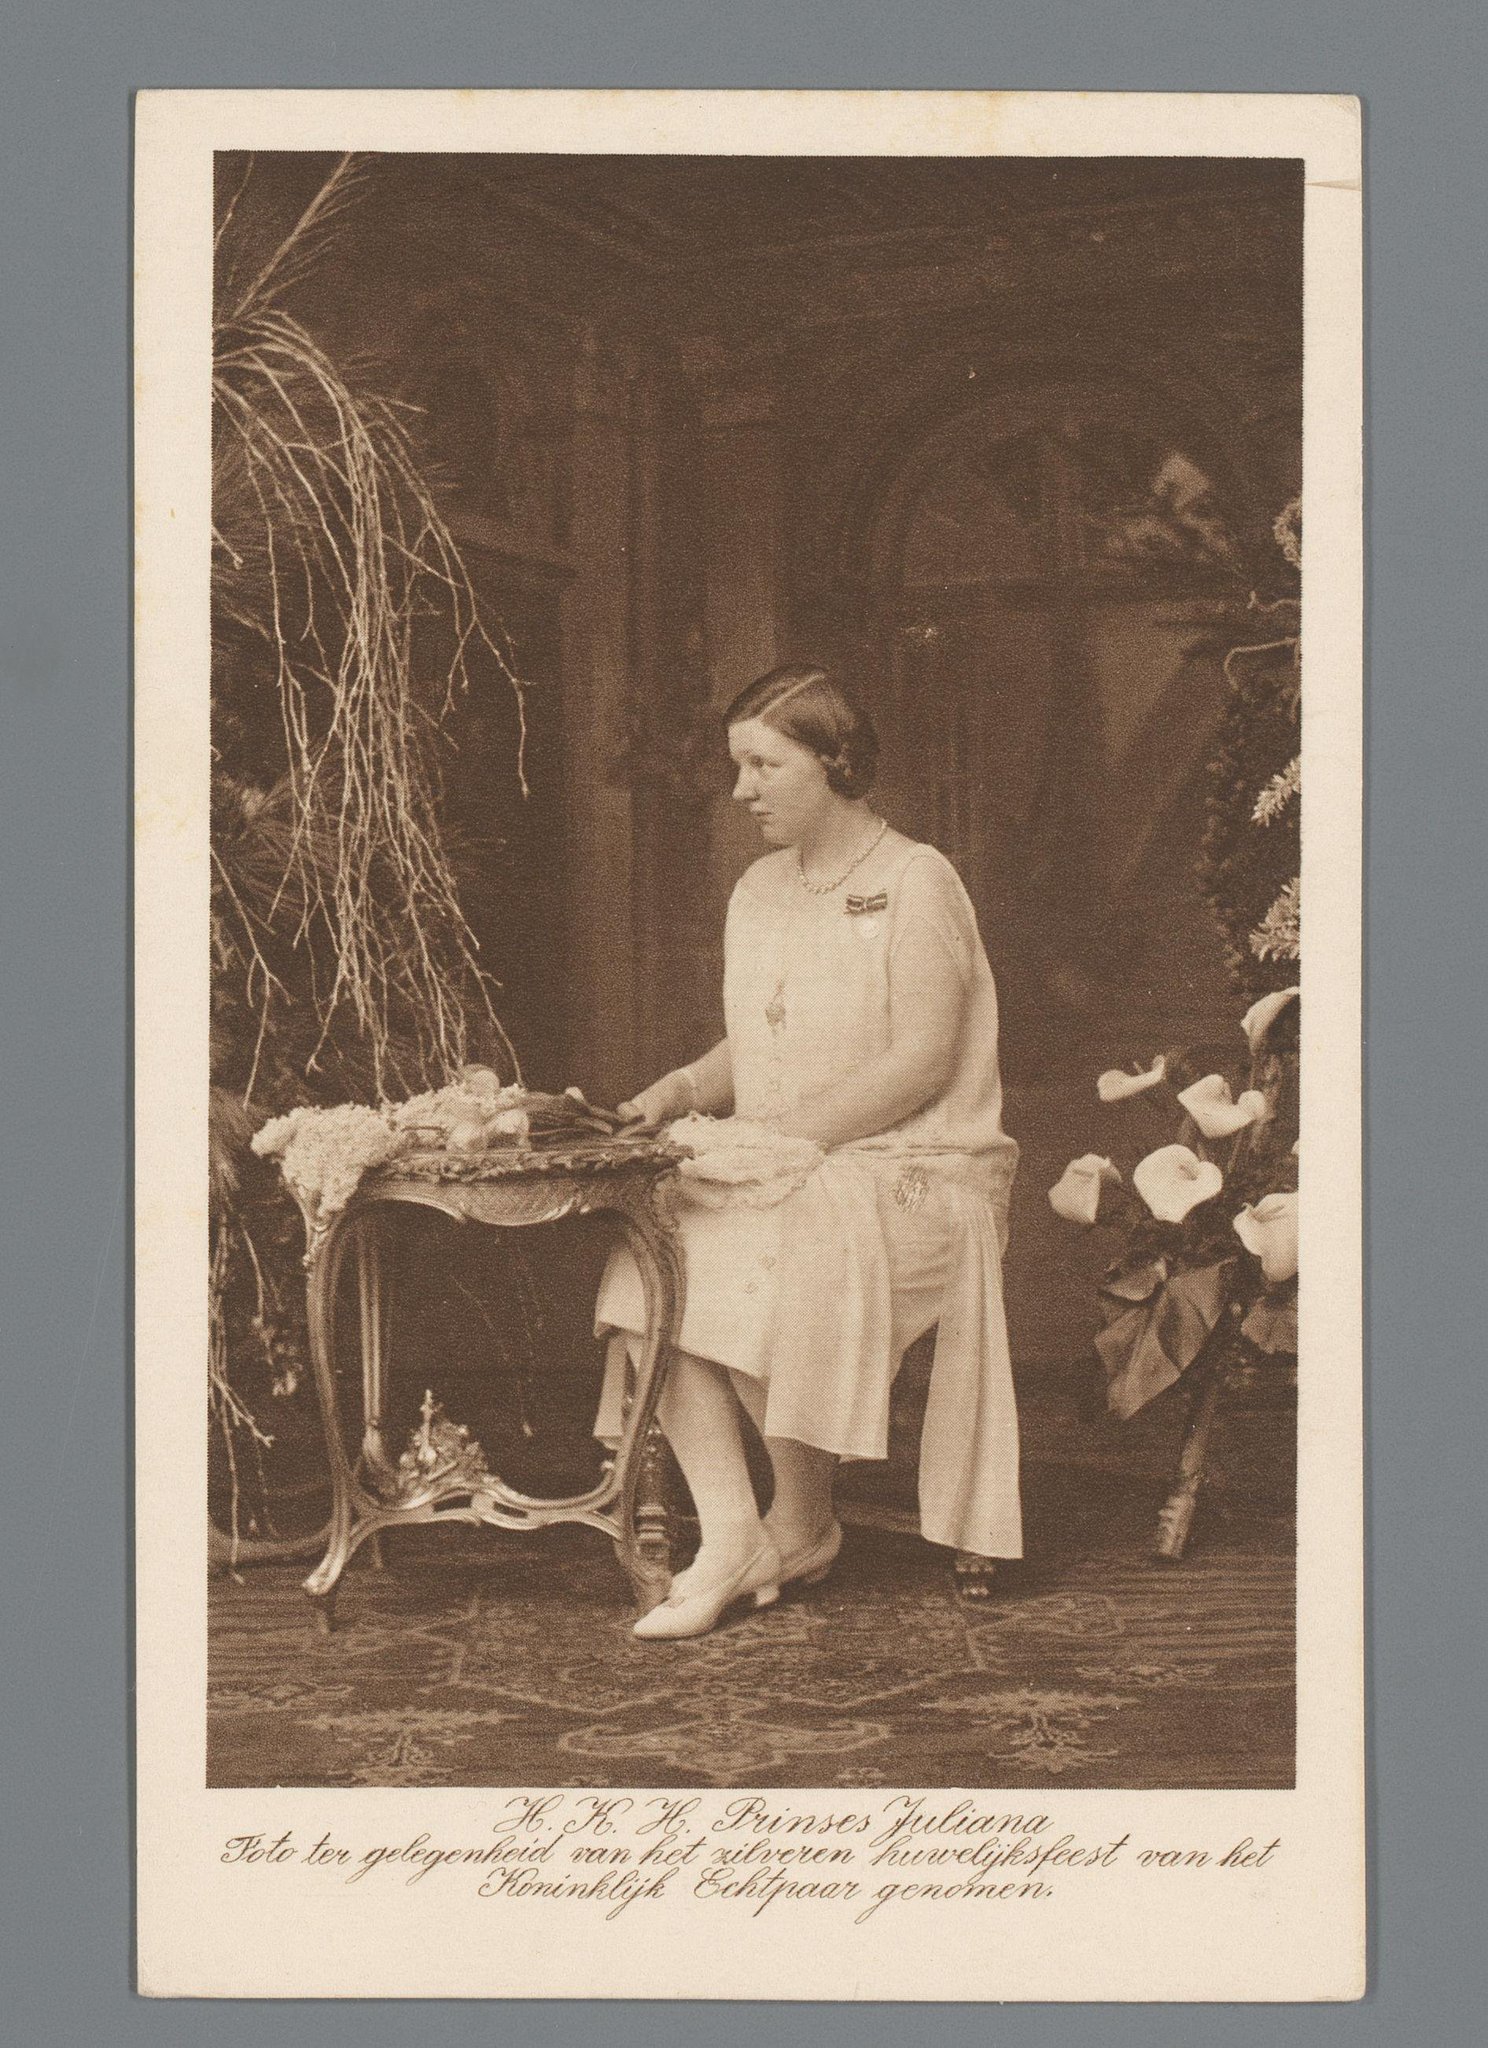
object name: ansichtkaart, prentbriefkaart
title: H. K. H. Prinses Juliana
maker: Anonymous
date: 1926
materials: paper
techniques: rotogravure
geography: leiden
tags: juliana of the netherlands, crown princess, historical persons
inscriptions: inscription: ‘- Nadruk Verboden.’, number: ‘7838’, inscription: ‘Foto ter gelegenheid van het zilveren huwelijksfeest van het/ Koninklijk Echtpaar genomen.’, number: ‘2.50.’